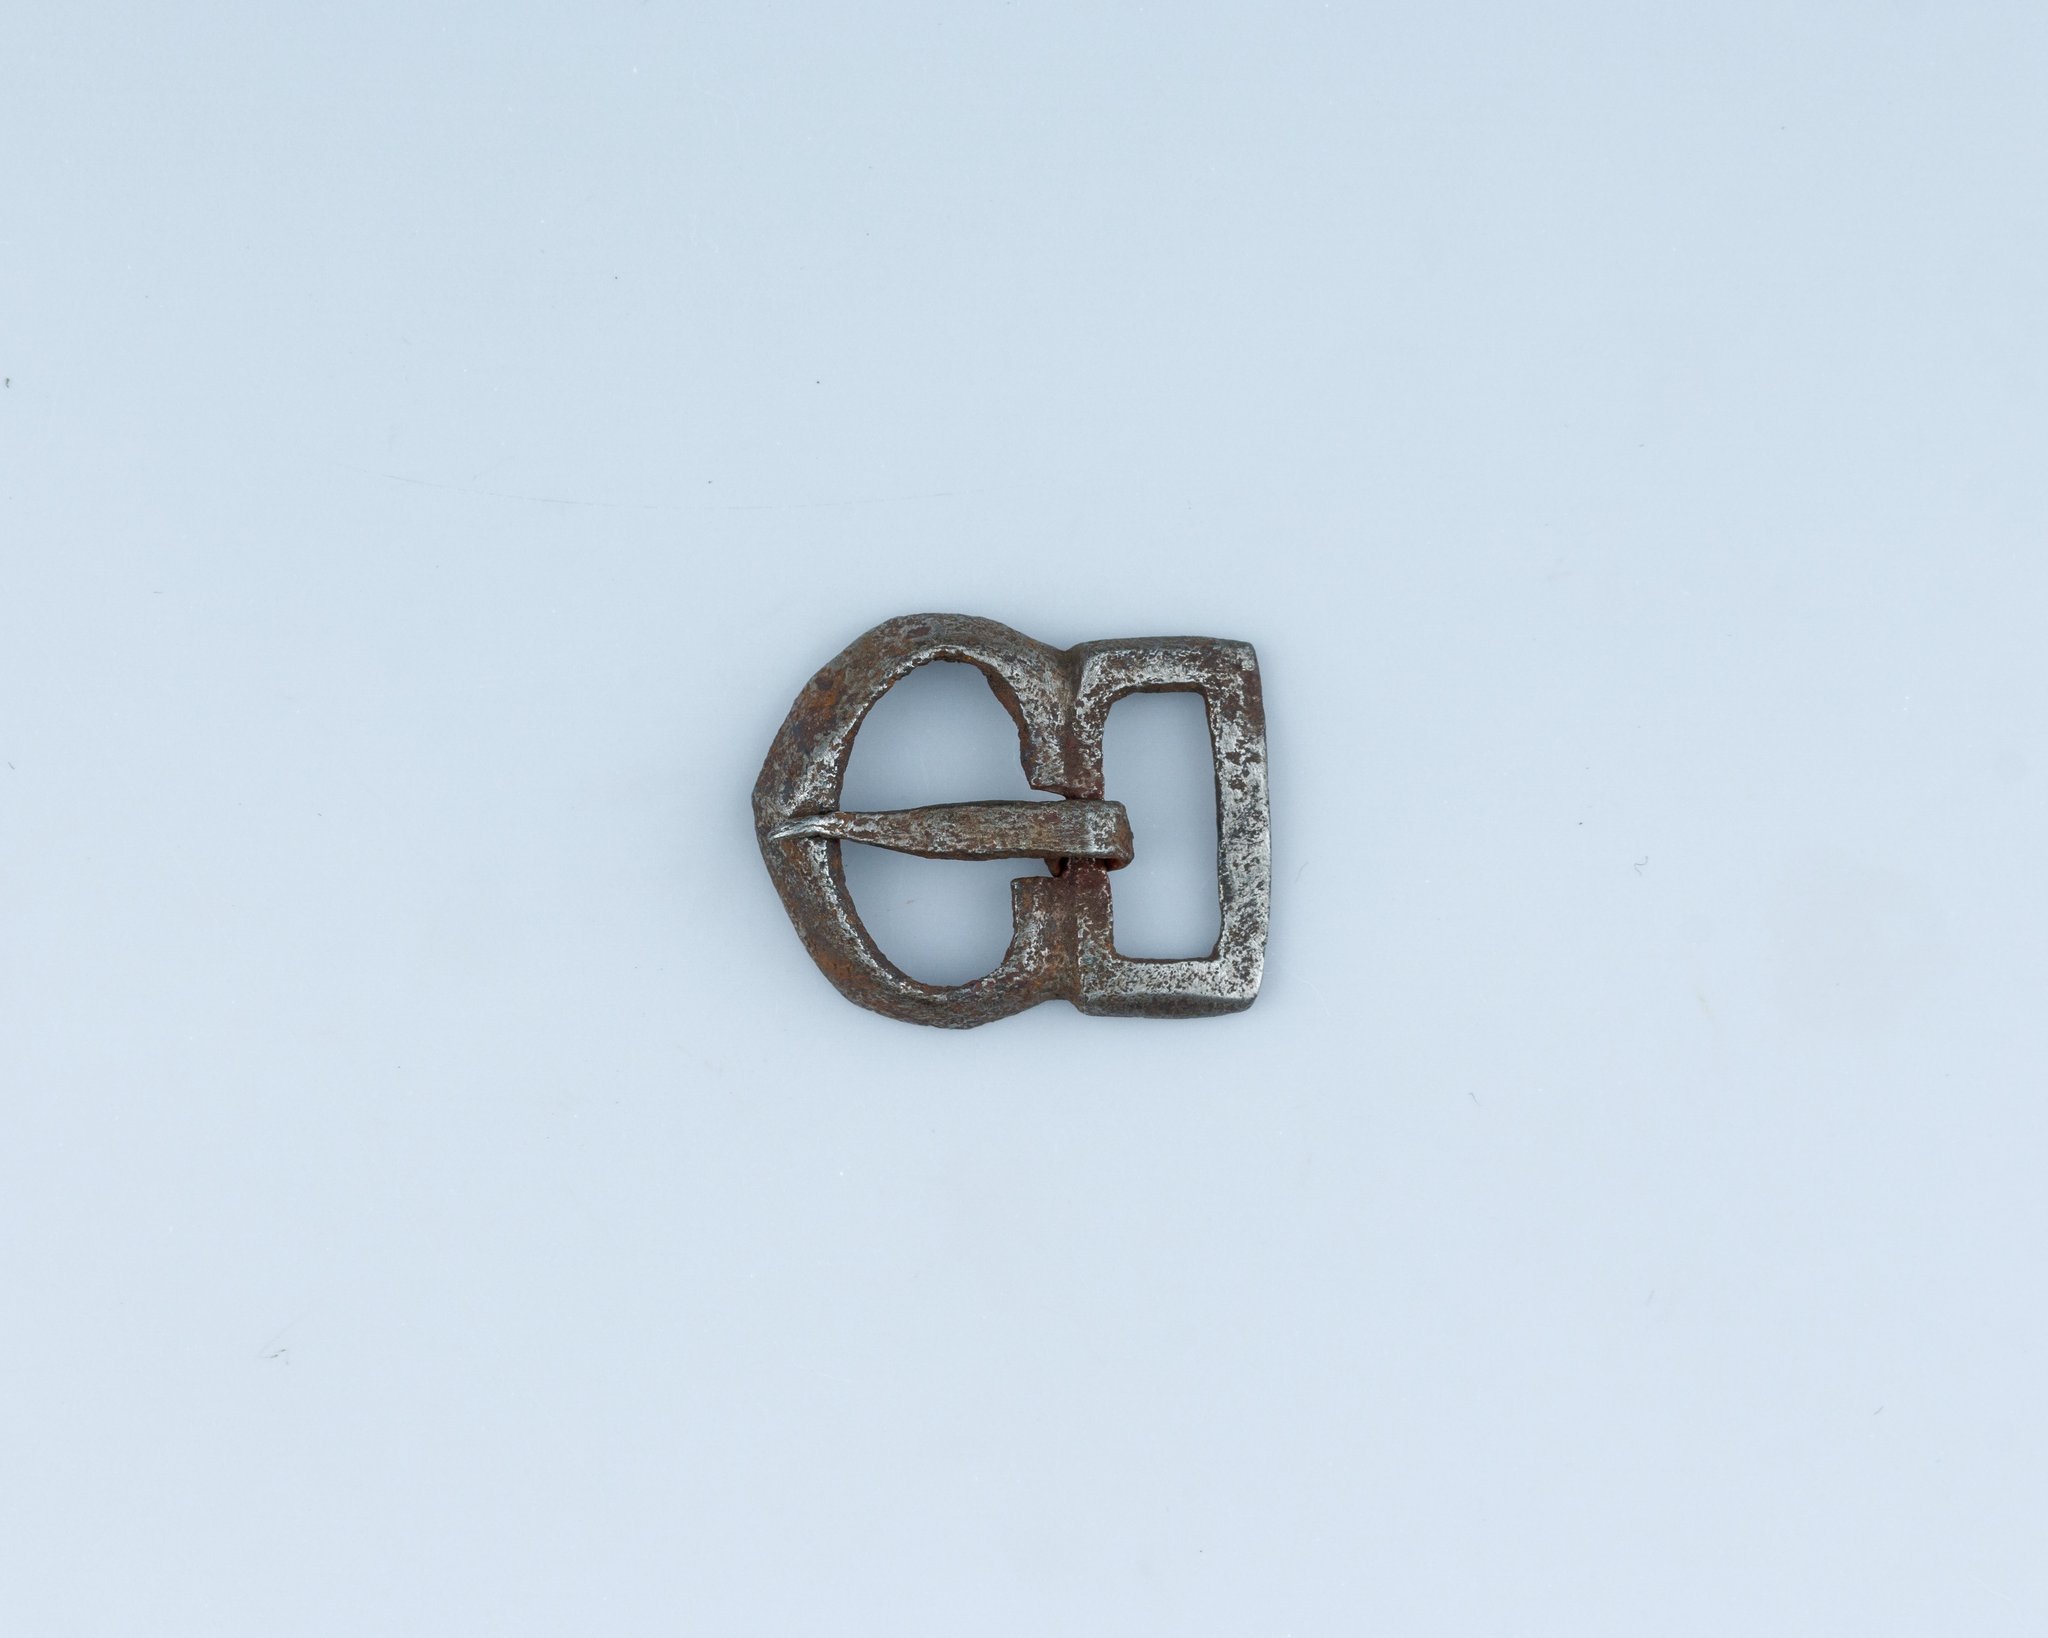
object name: buckle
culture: european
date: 1401-1700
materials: steel